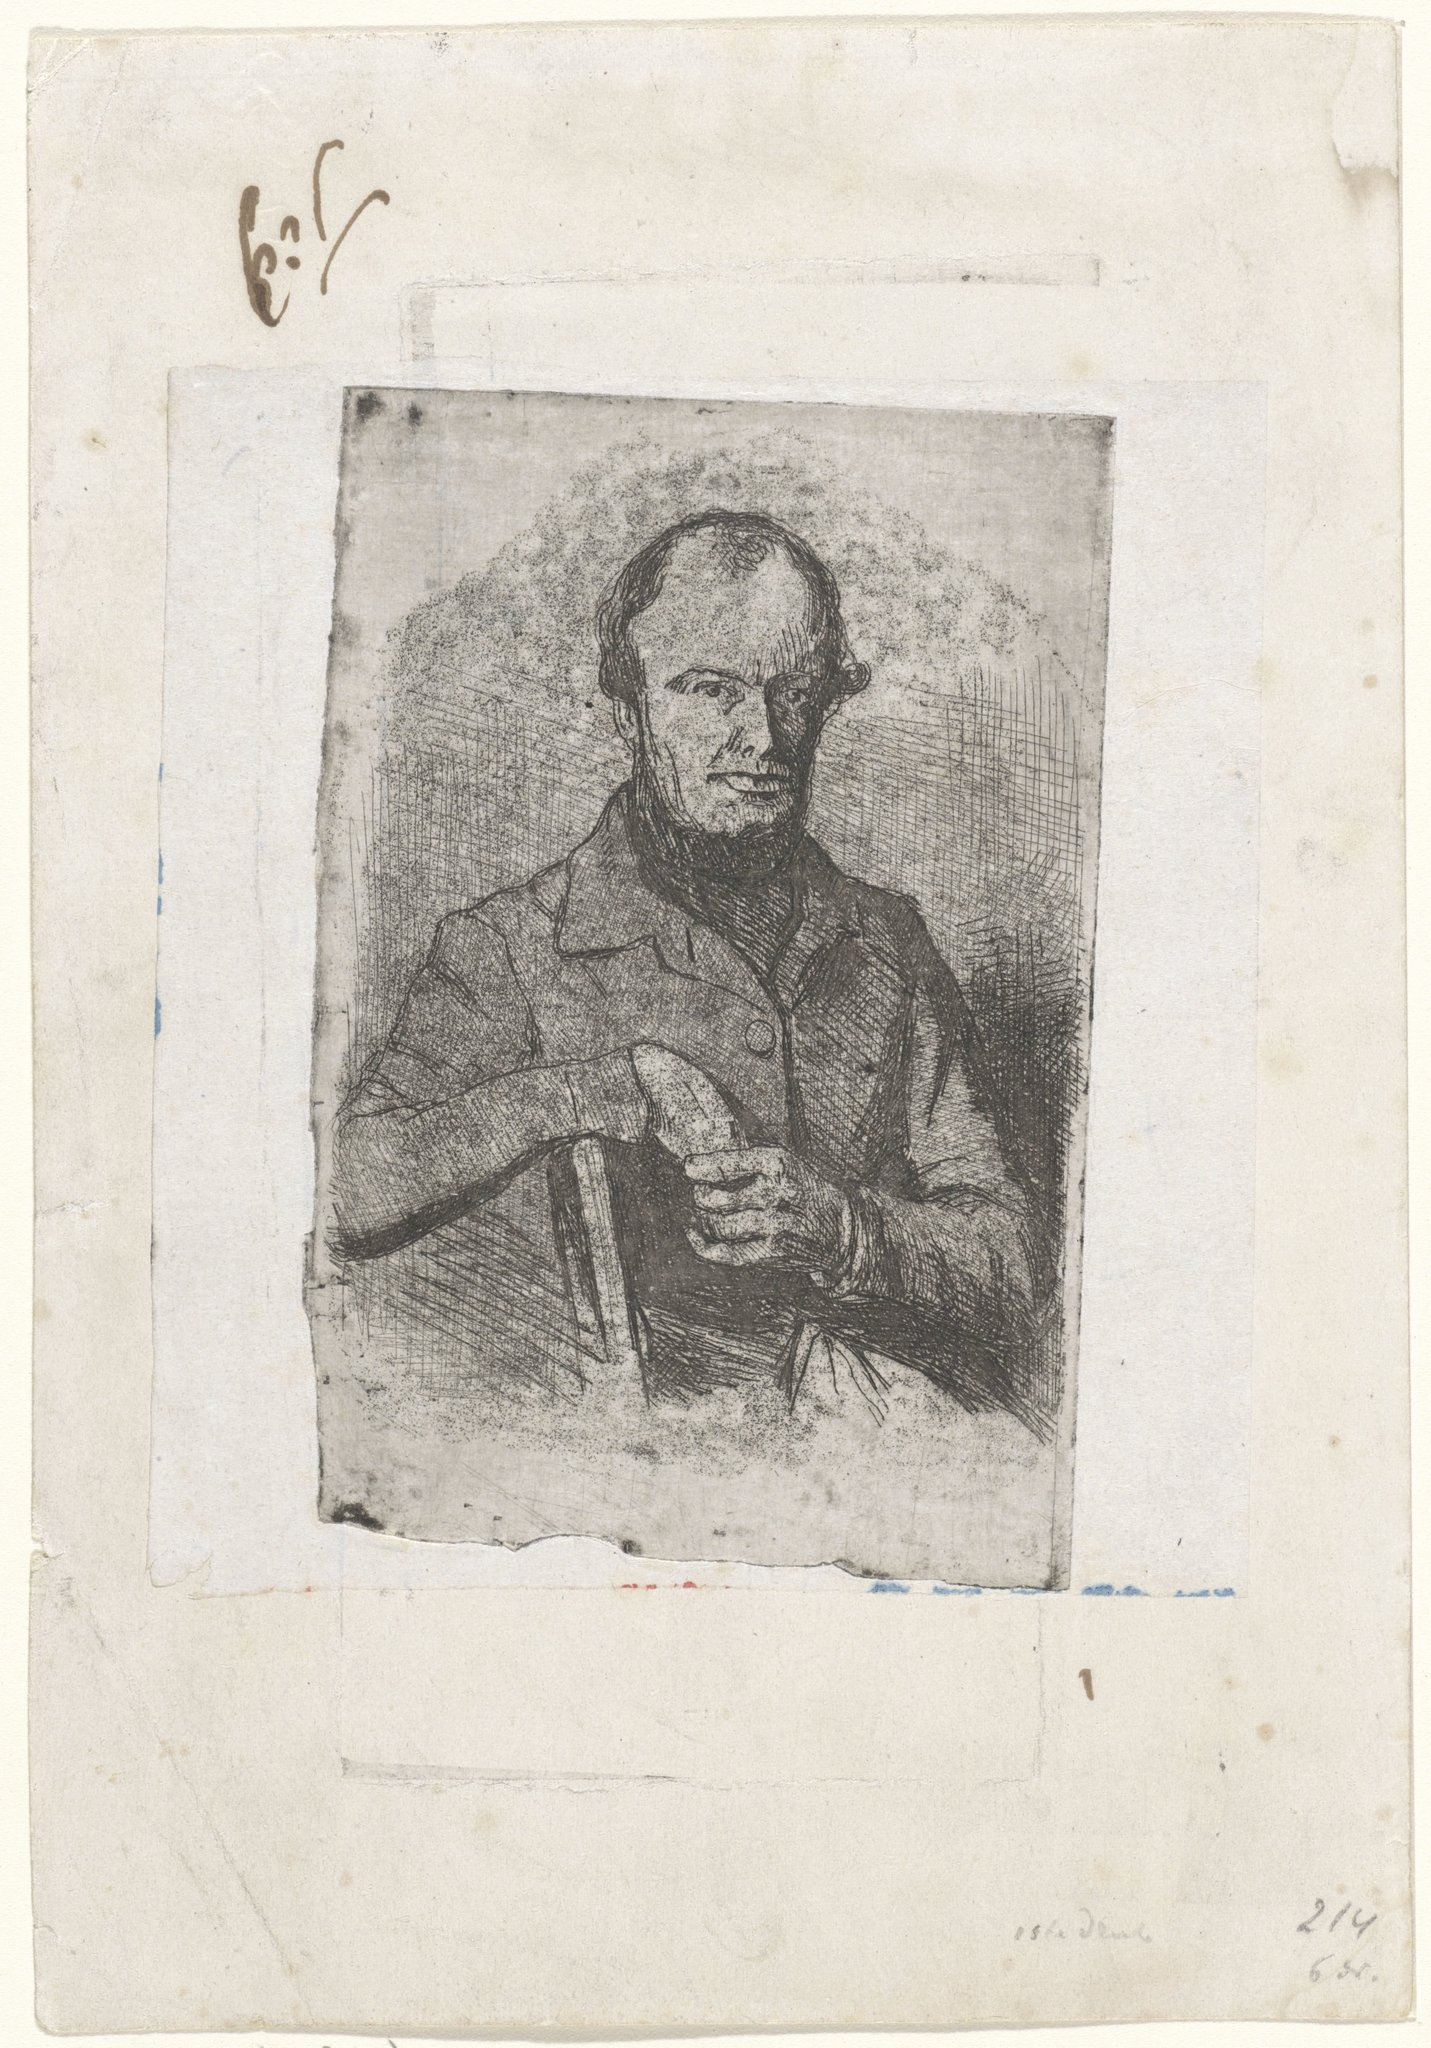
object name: print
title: Portret van Johannes Adrianus van der Drift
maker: jan weissenbruch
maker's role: painter, print maker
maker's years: 1822-1880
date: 1850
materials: paper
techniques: etching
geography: the hague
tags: johannes adrianus van der drift, historical persons, portrait, self-portrait of artist, chair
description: Portret van Johannes Adrianus van der Drift, kunstenaar. Hij zit op een stoel.